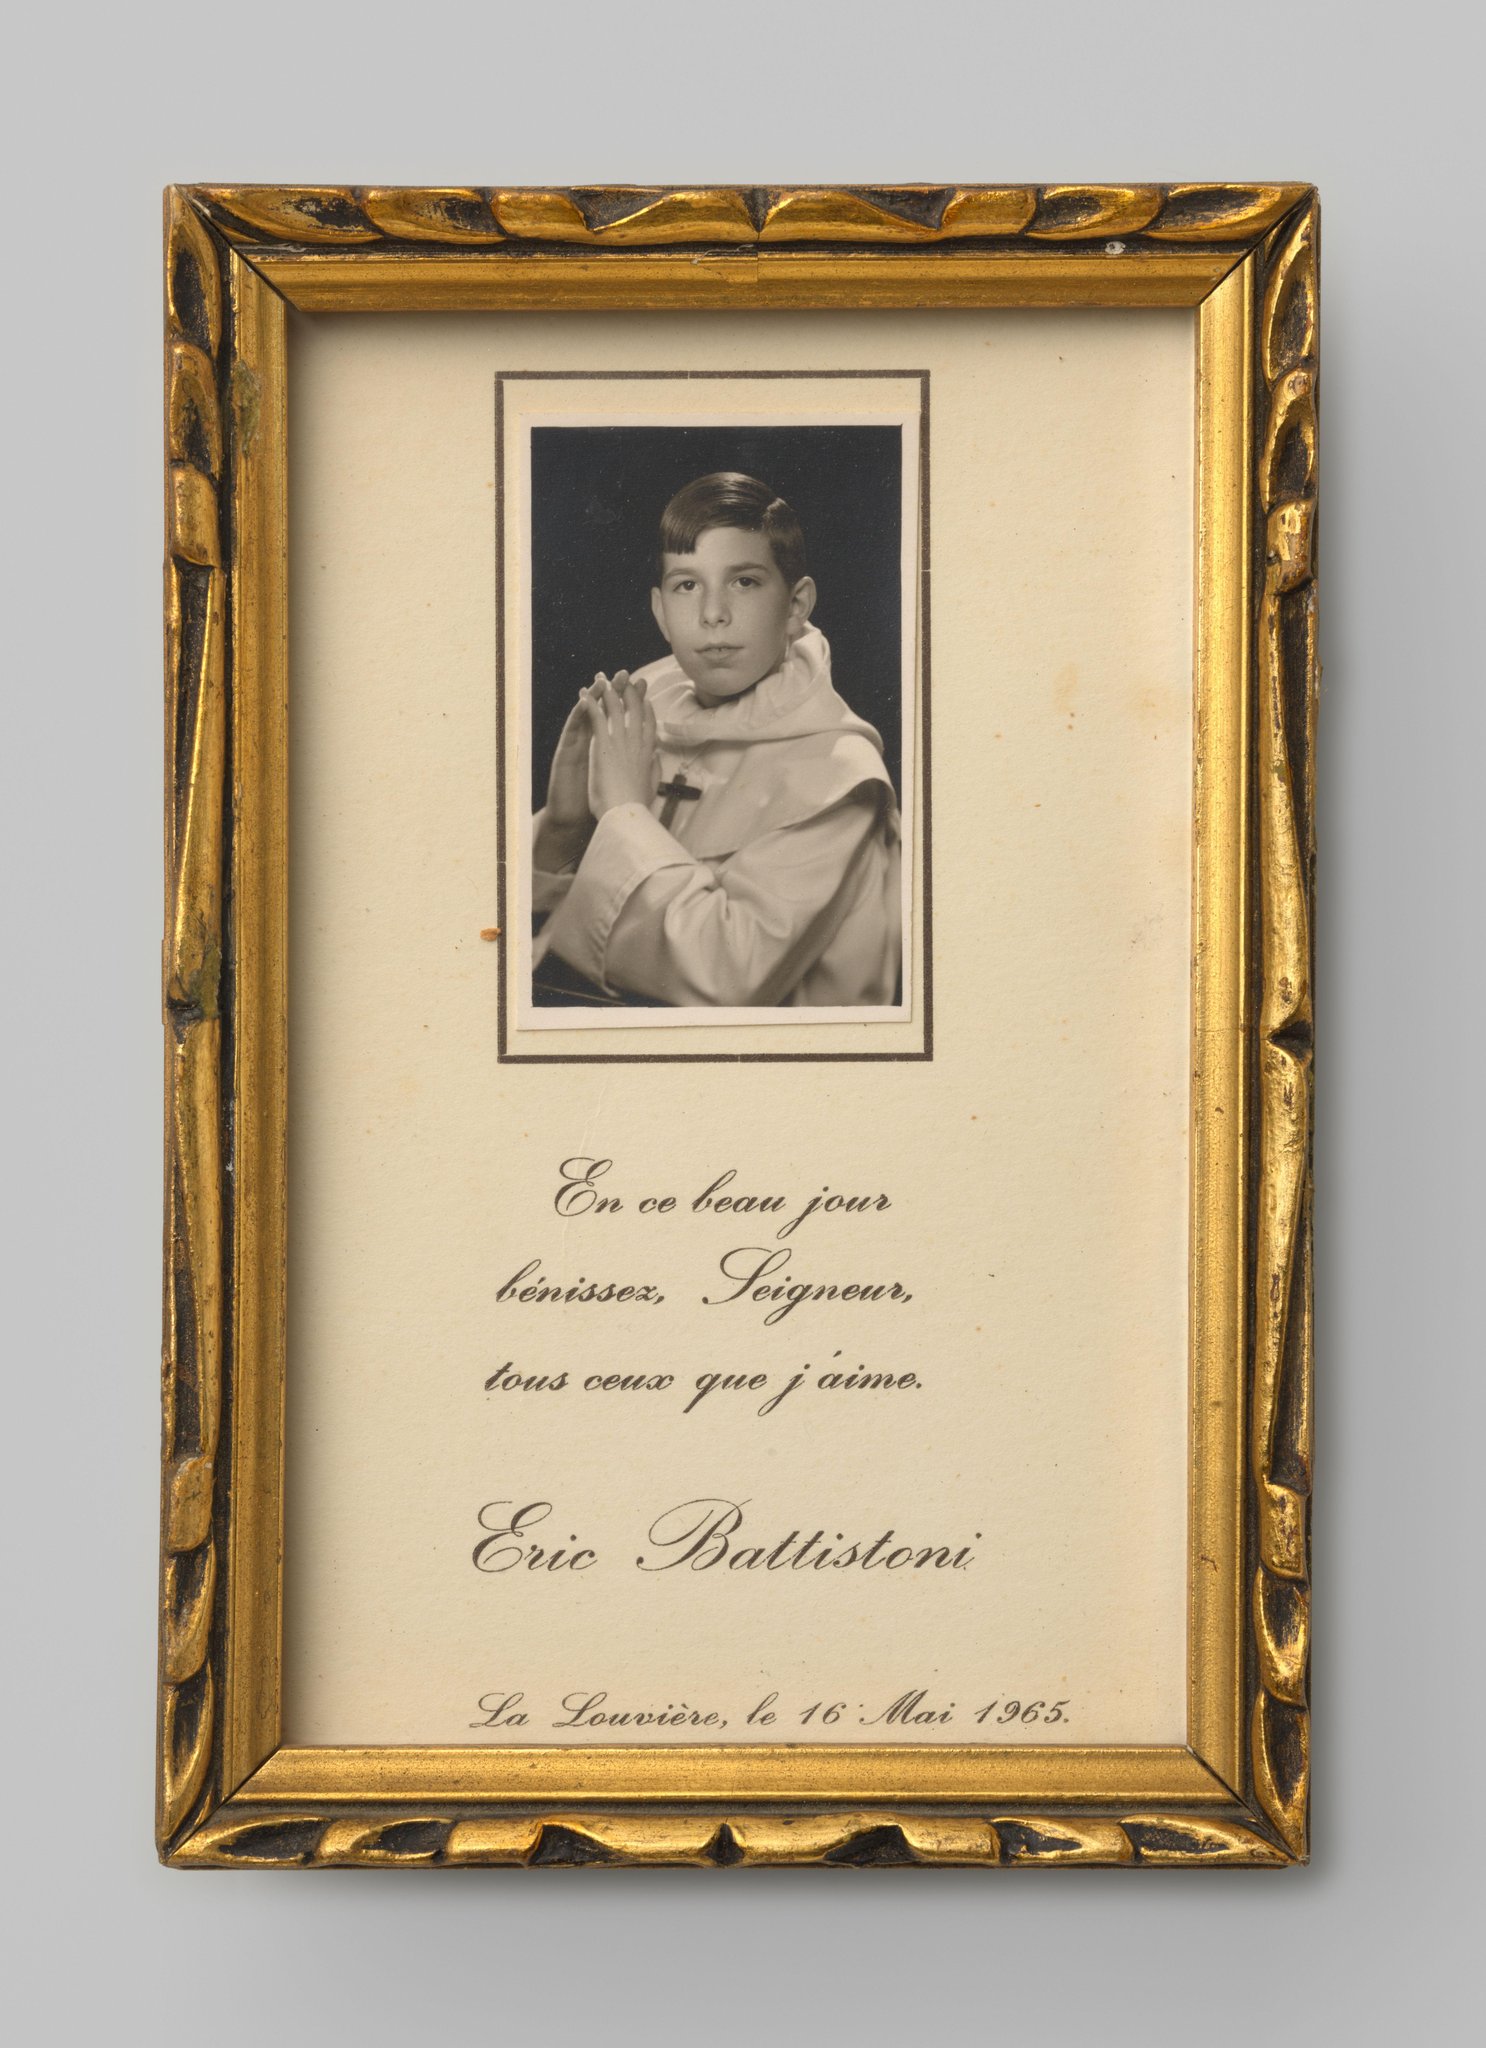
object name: photograph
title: Portret van een onbekende jongen met zijn handen gevouwen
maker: Anonymous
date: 1965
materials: paper, cardboard, glass, metal, wood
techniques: gelatin silver print, gilding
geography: la louvière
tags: boy (child between toddler and youth), anonymous historical person portrayed alone, hands folded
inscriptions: : ‘Eric Battistoni’